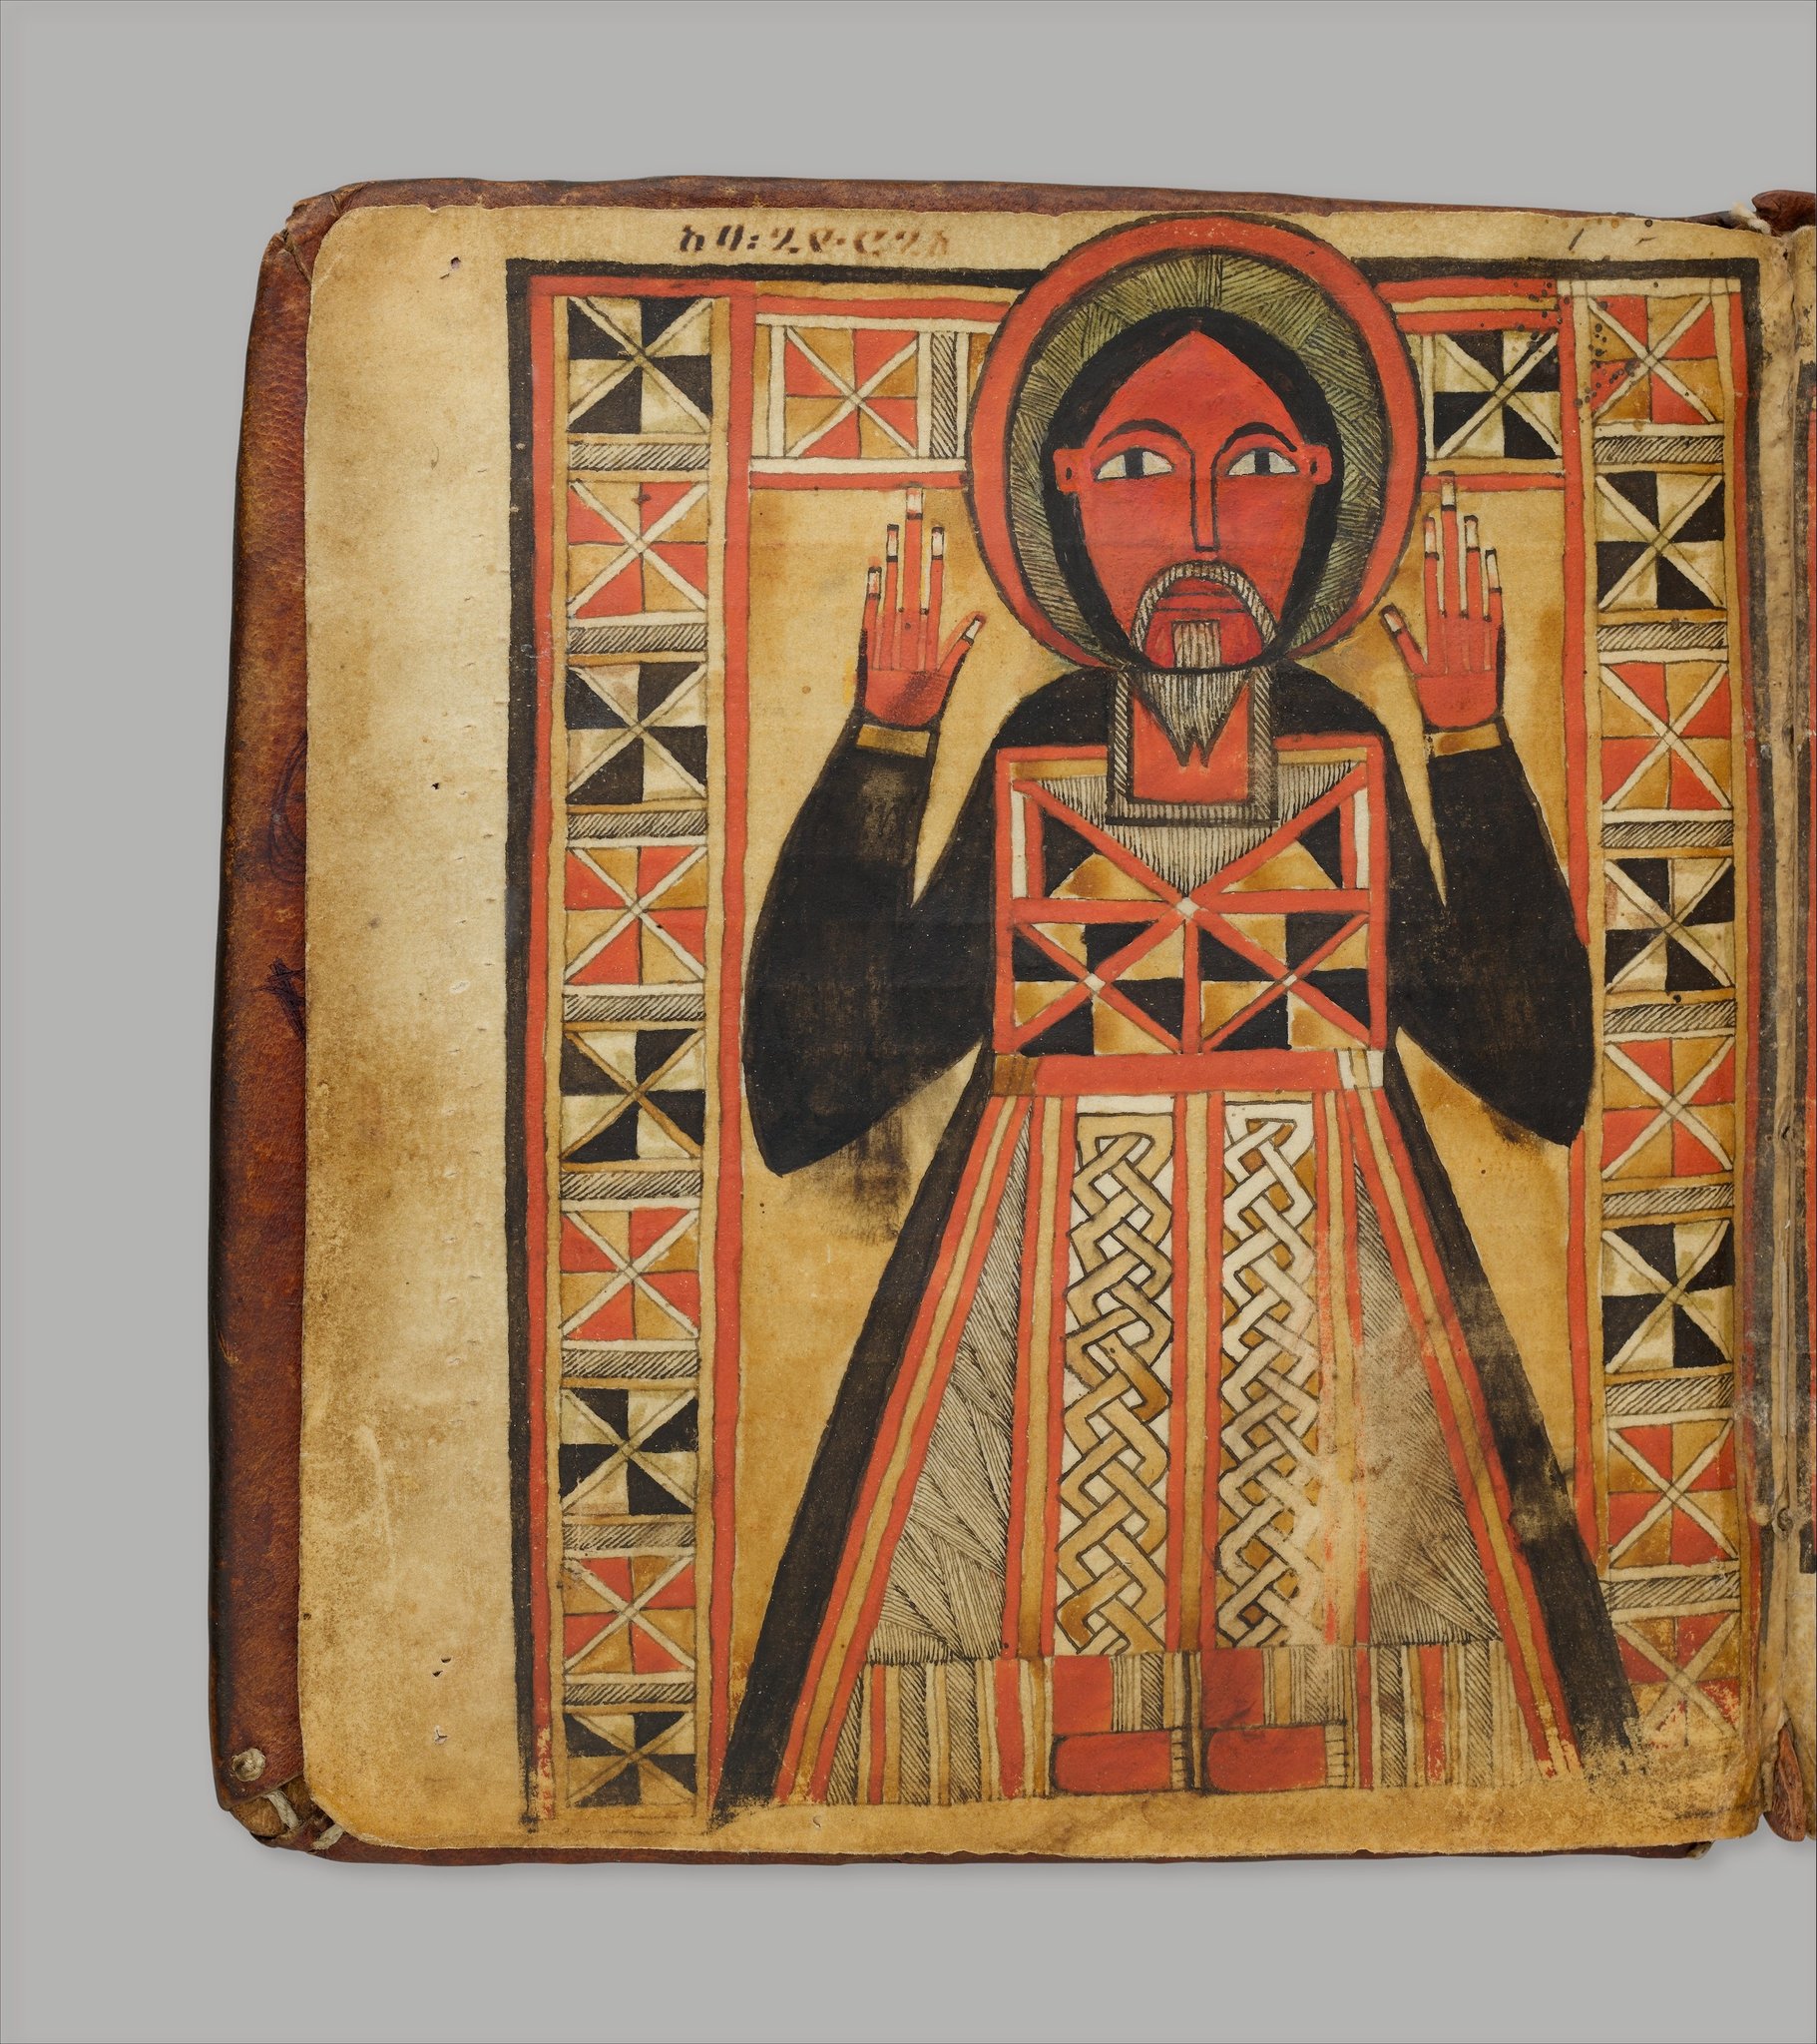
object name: book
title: Arganonä Maryam (The Organ of Mary) prayer book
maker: baselyos (the ground hornbill master)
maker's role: artist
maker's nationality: ethiopian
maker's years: 1650-1700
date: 1667-1700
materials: fiber, ink, leather, parchment, pigment, wood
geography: ethiopia